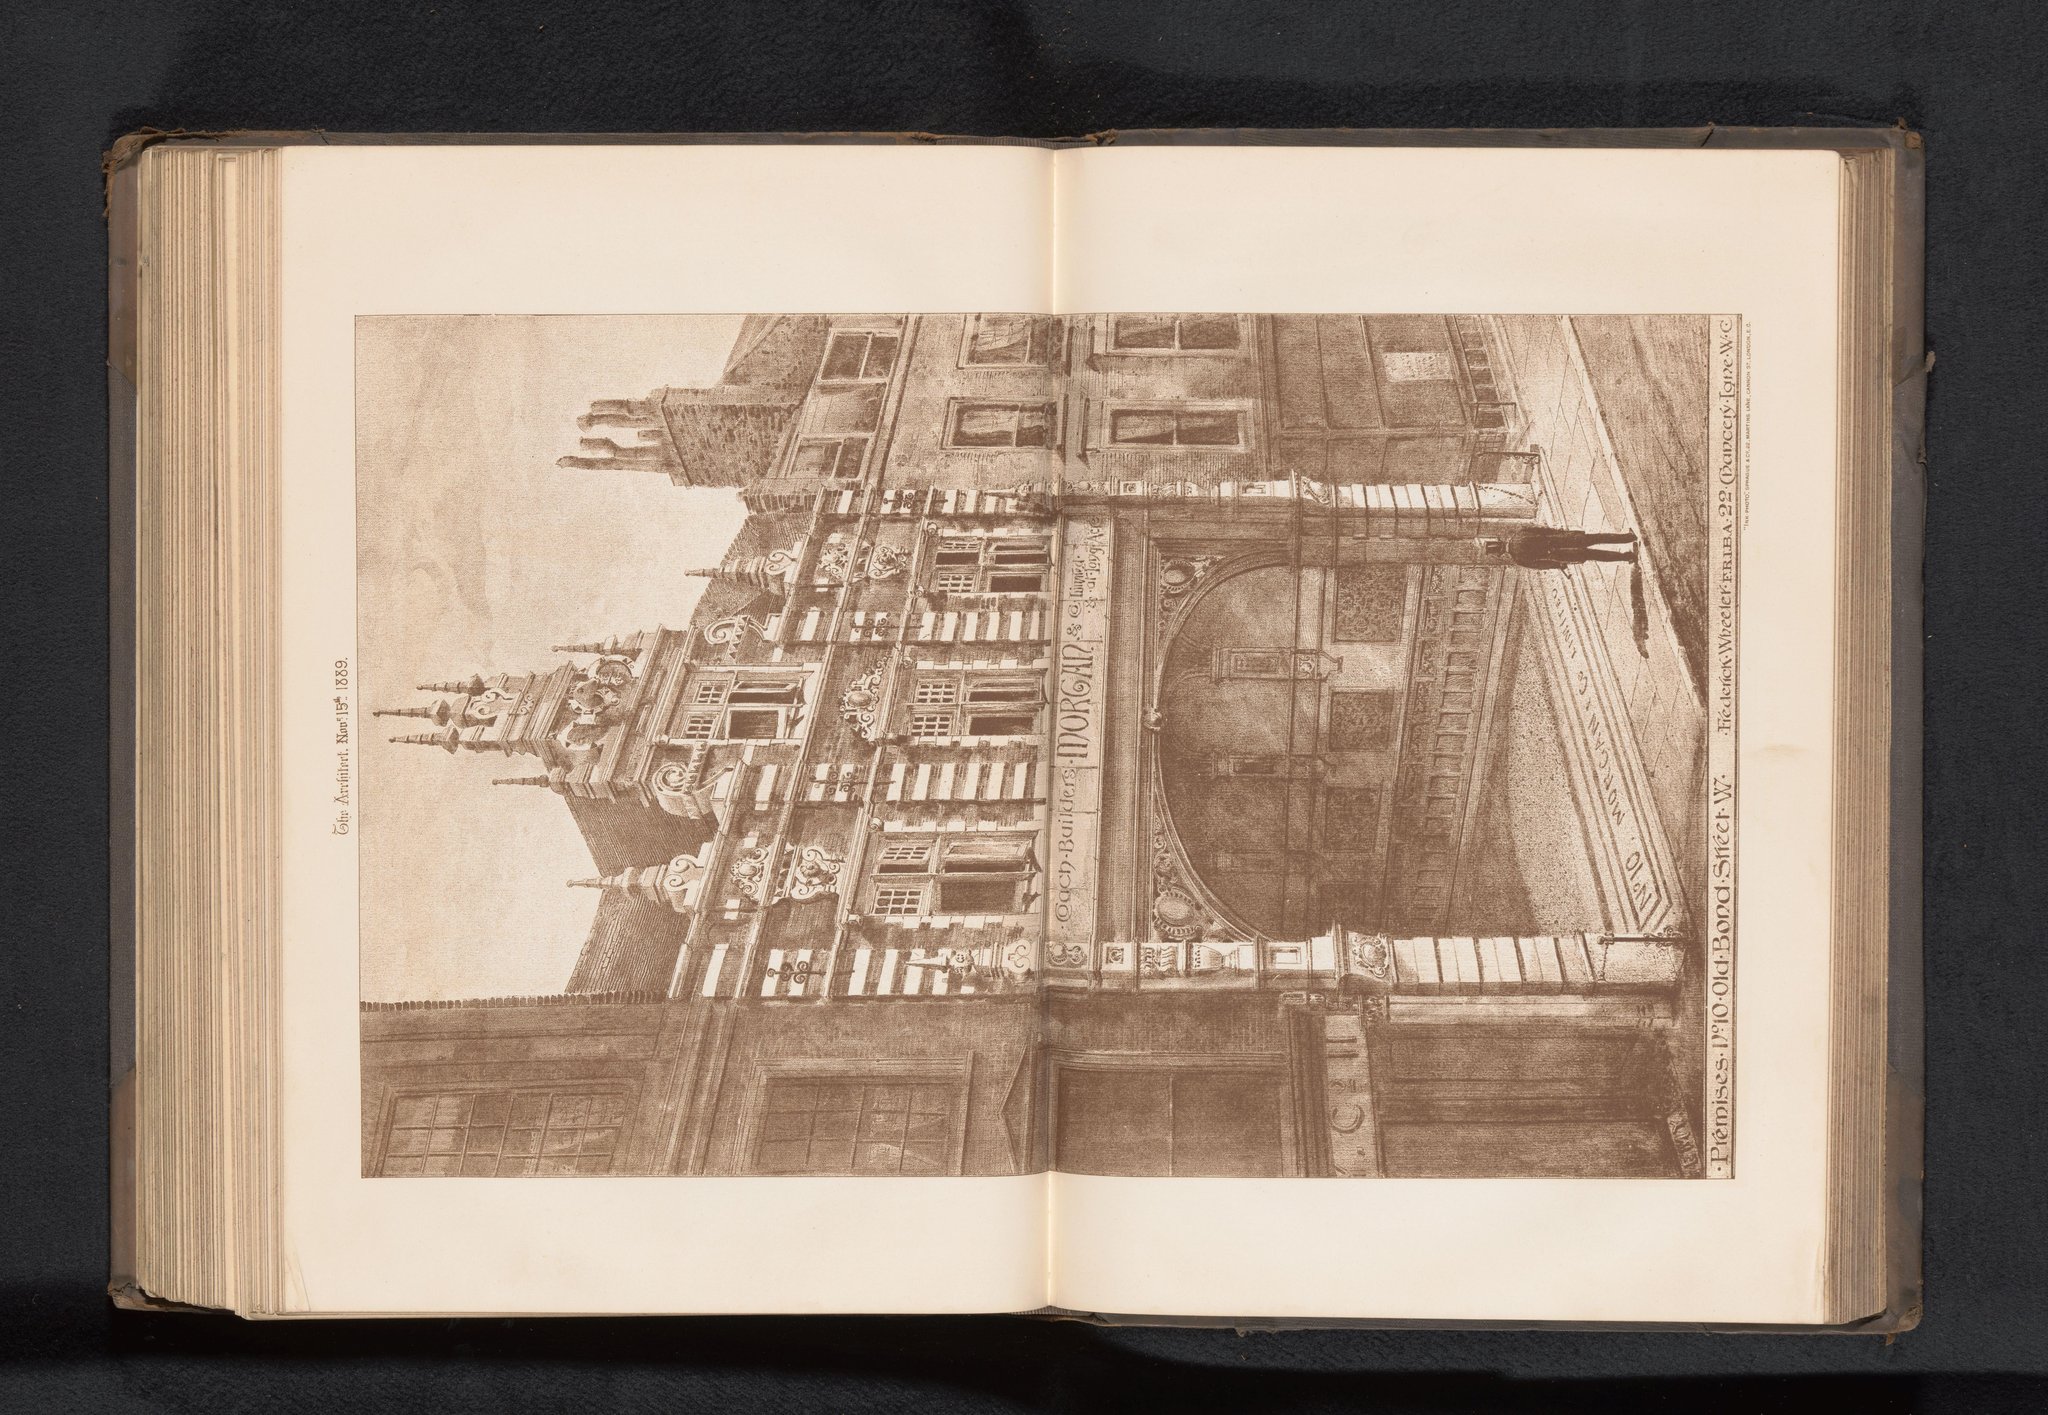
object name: photomechanical print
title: Reproductie van een tekening van de passage in Old Bond Street te Londen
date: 1884-1889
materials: paper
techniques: photolithography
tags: passage (+ city(-scape) with figures, staffage)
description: Prent op zesde ongenummerde pagina na pagina 284.